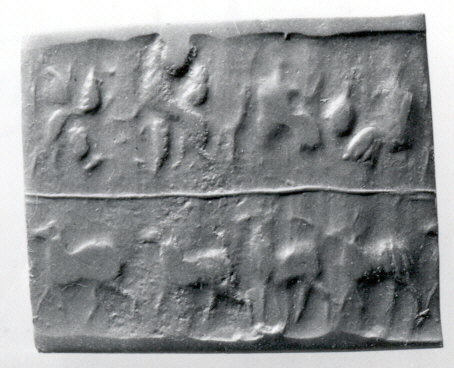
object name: cylinder seal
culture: sumerian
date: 2600-2350 BCE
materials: stone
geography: mesopotamia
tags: animals